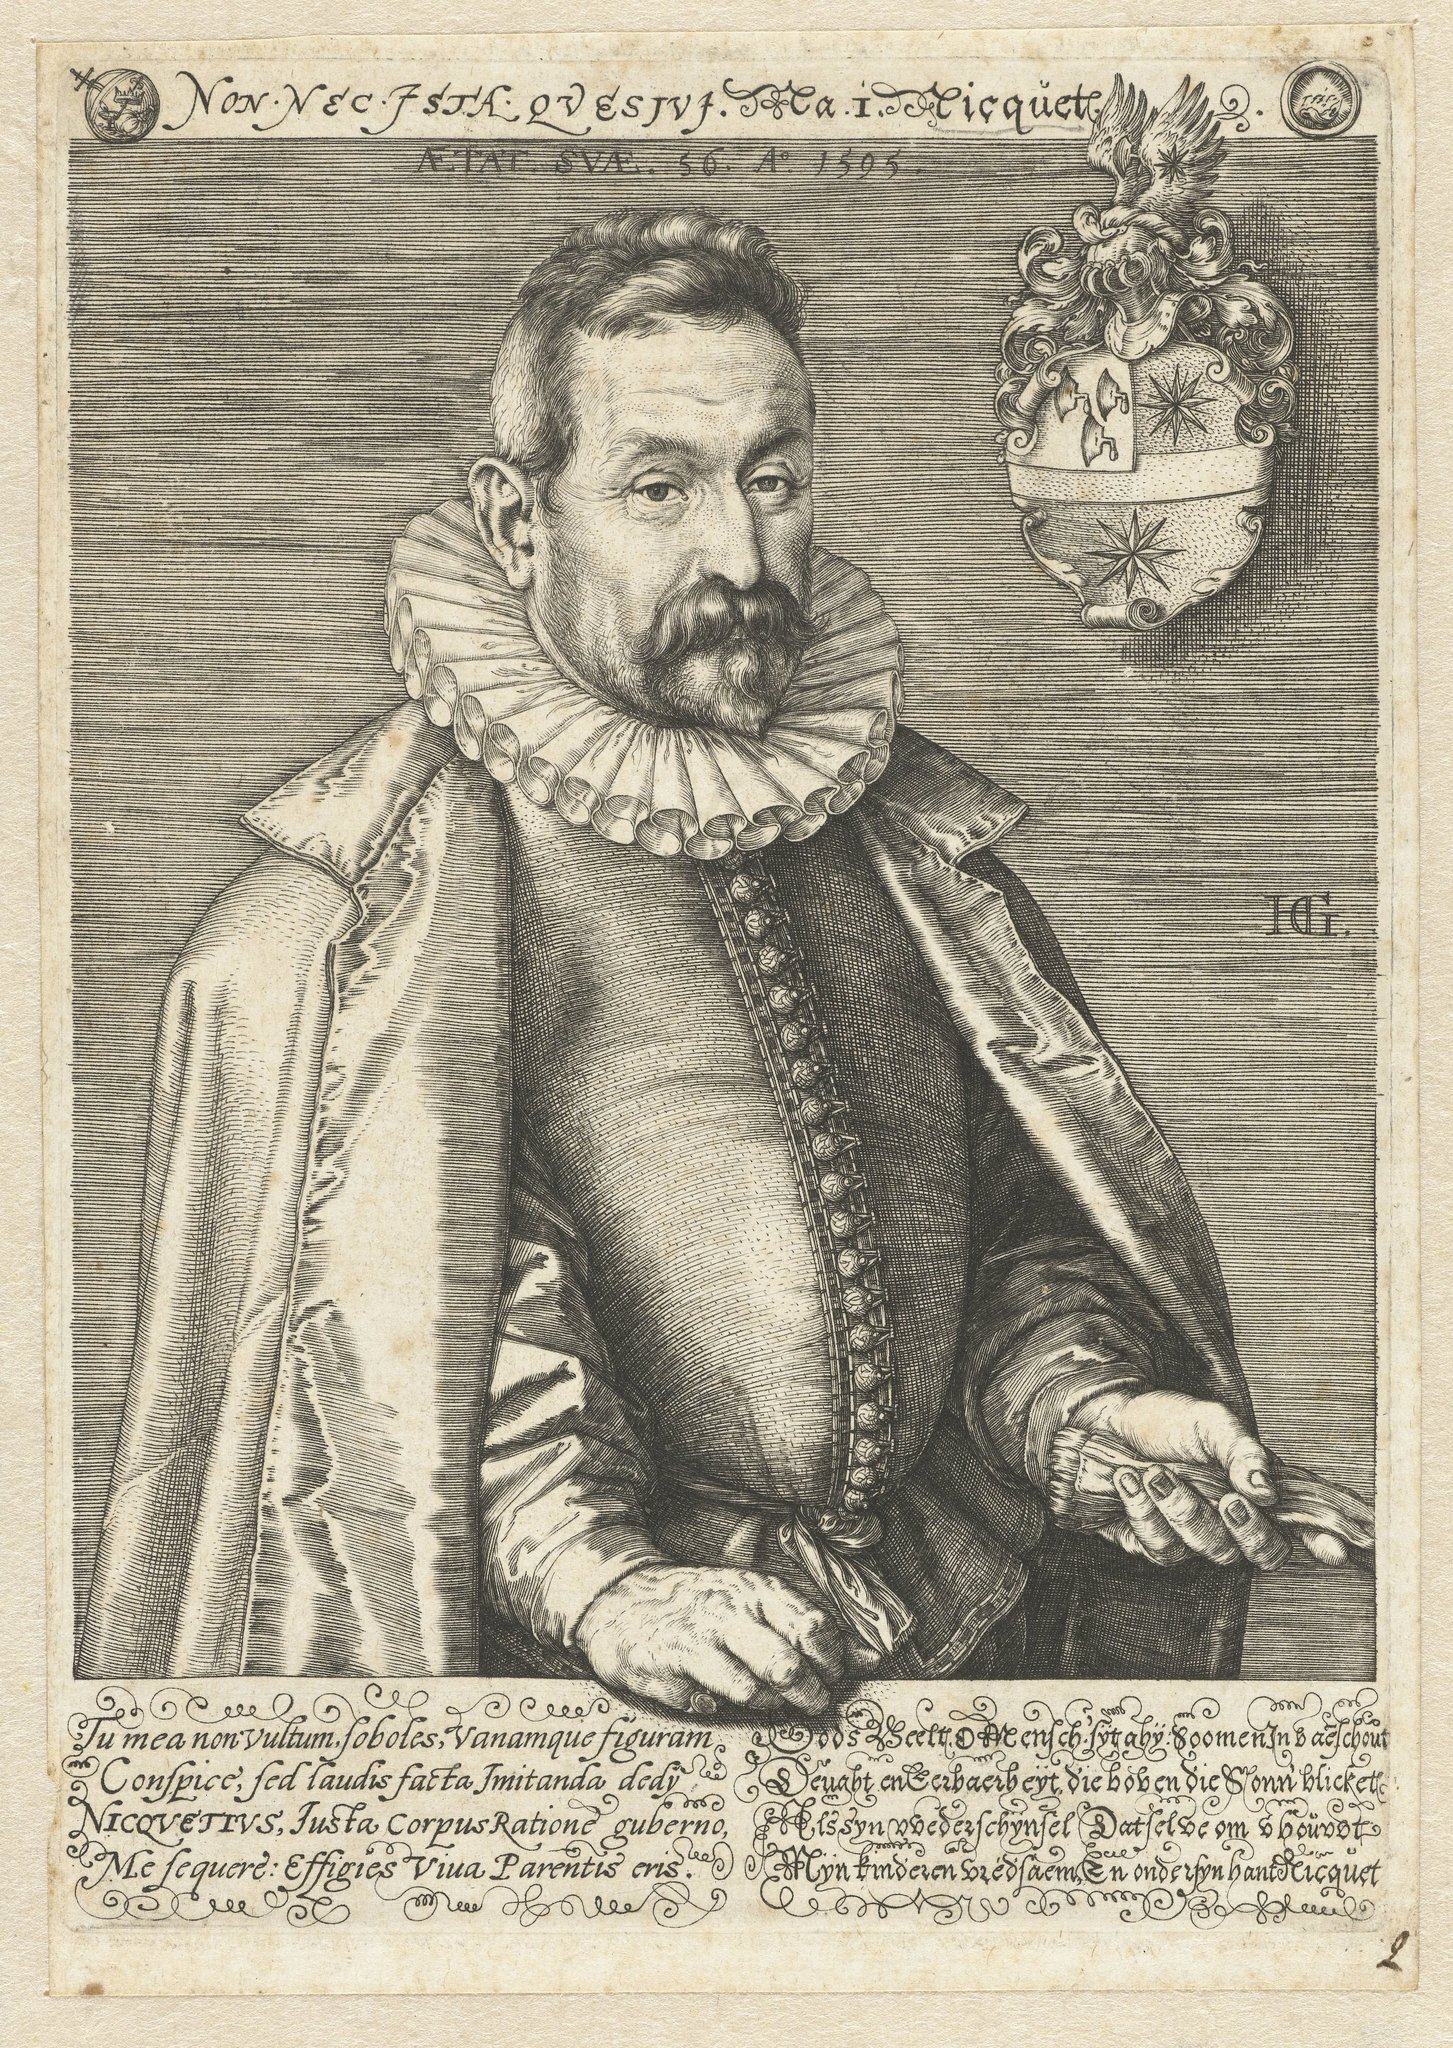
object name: print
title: Non. Nec. Ista. Quesivi. Ma. I. Nicquet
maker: hendrick goltzius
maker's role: draughtsman, painter, print maker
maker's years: 1558-1617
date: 1595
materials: paper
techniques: engraving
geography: haarlem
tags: antwerp, amsterdam, jan nicquet, historical persons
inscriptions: collector's mark: Lugt 10, monogram: ‘HG.’, collector's mark: Lugt 11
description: Portret van Jan Nicquet (1539-1608), koopman en kunstverzamelaar, ten halven lijve weergegeven. Onder de voorstelling vier regels Latijnse en vier regels Nederlandse tekst in kalligrafie. Vertaling Latijnse tekst: U, mijn zoon, kijk niet naar mijn gezicht of louter naar mijn uiterlijk, maar ik heb ook loffelijke, navolgenswaardige daden verricht. Ik, Nicquet, stuur mijn Lichaam op de Juiste Manier. Volg mij en gij zult het Levende Evenbeeld van uw vader zijn.